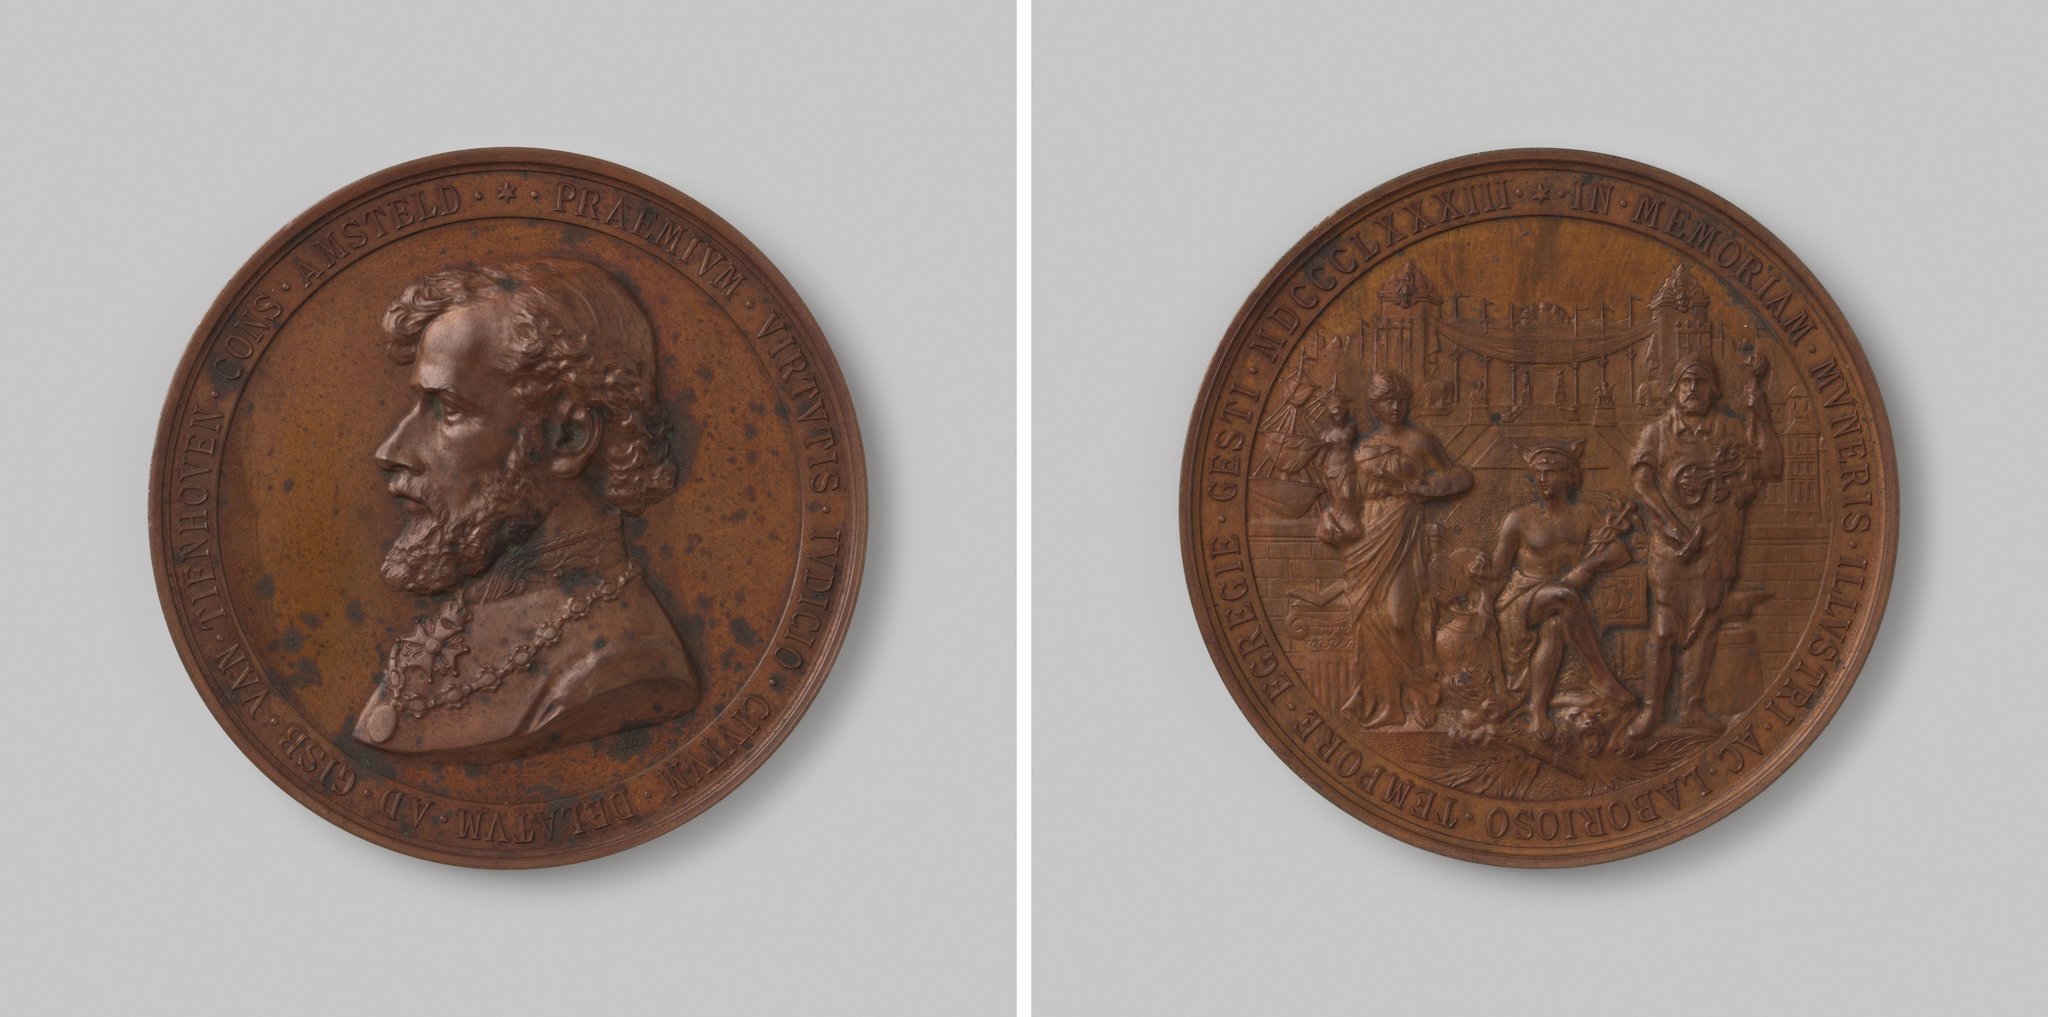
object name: history medal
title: Gisb. van Tienhoven burgemeester van Amsterdam 1883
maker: jacob samuel cohen elion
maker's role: draughtsman, painter, print maker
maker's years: 1840-1893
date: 1883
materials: bronze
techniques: striking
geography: amsterdam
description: Bronzen penning, op de voorzijde het borstbeeld van Van Tienhoven naar links met omschrift, op de keerzijde Mercurius tronend tussen de Kunst en een smid te midden van symbolen van bouwkunde en metaalnijverheid, op de achtergrond het tentoonstellingsgebouw te Amsterdam, met omschrift.